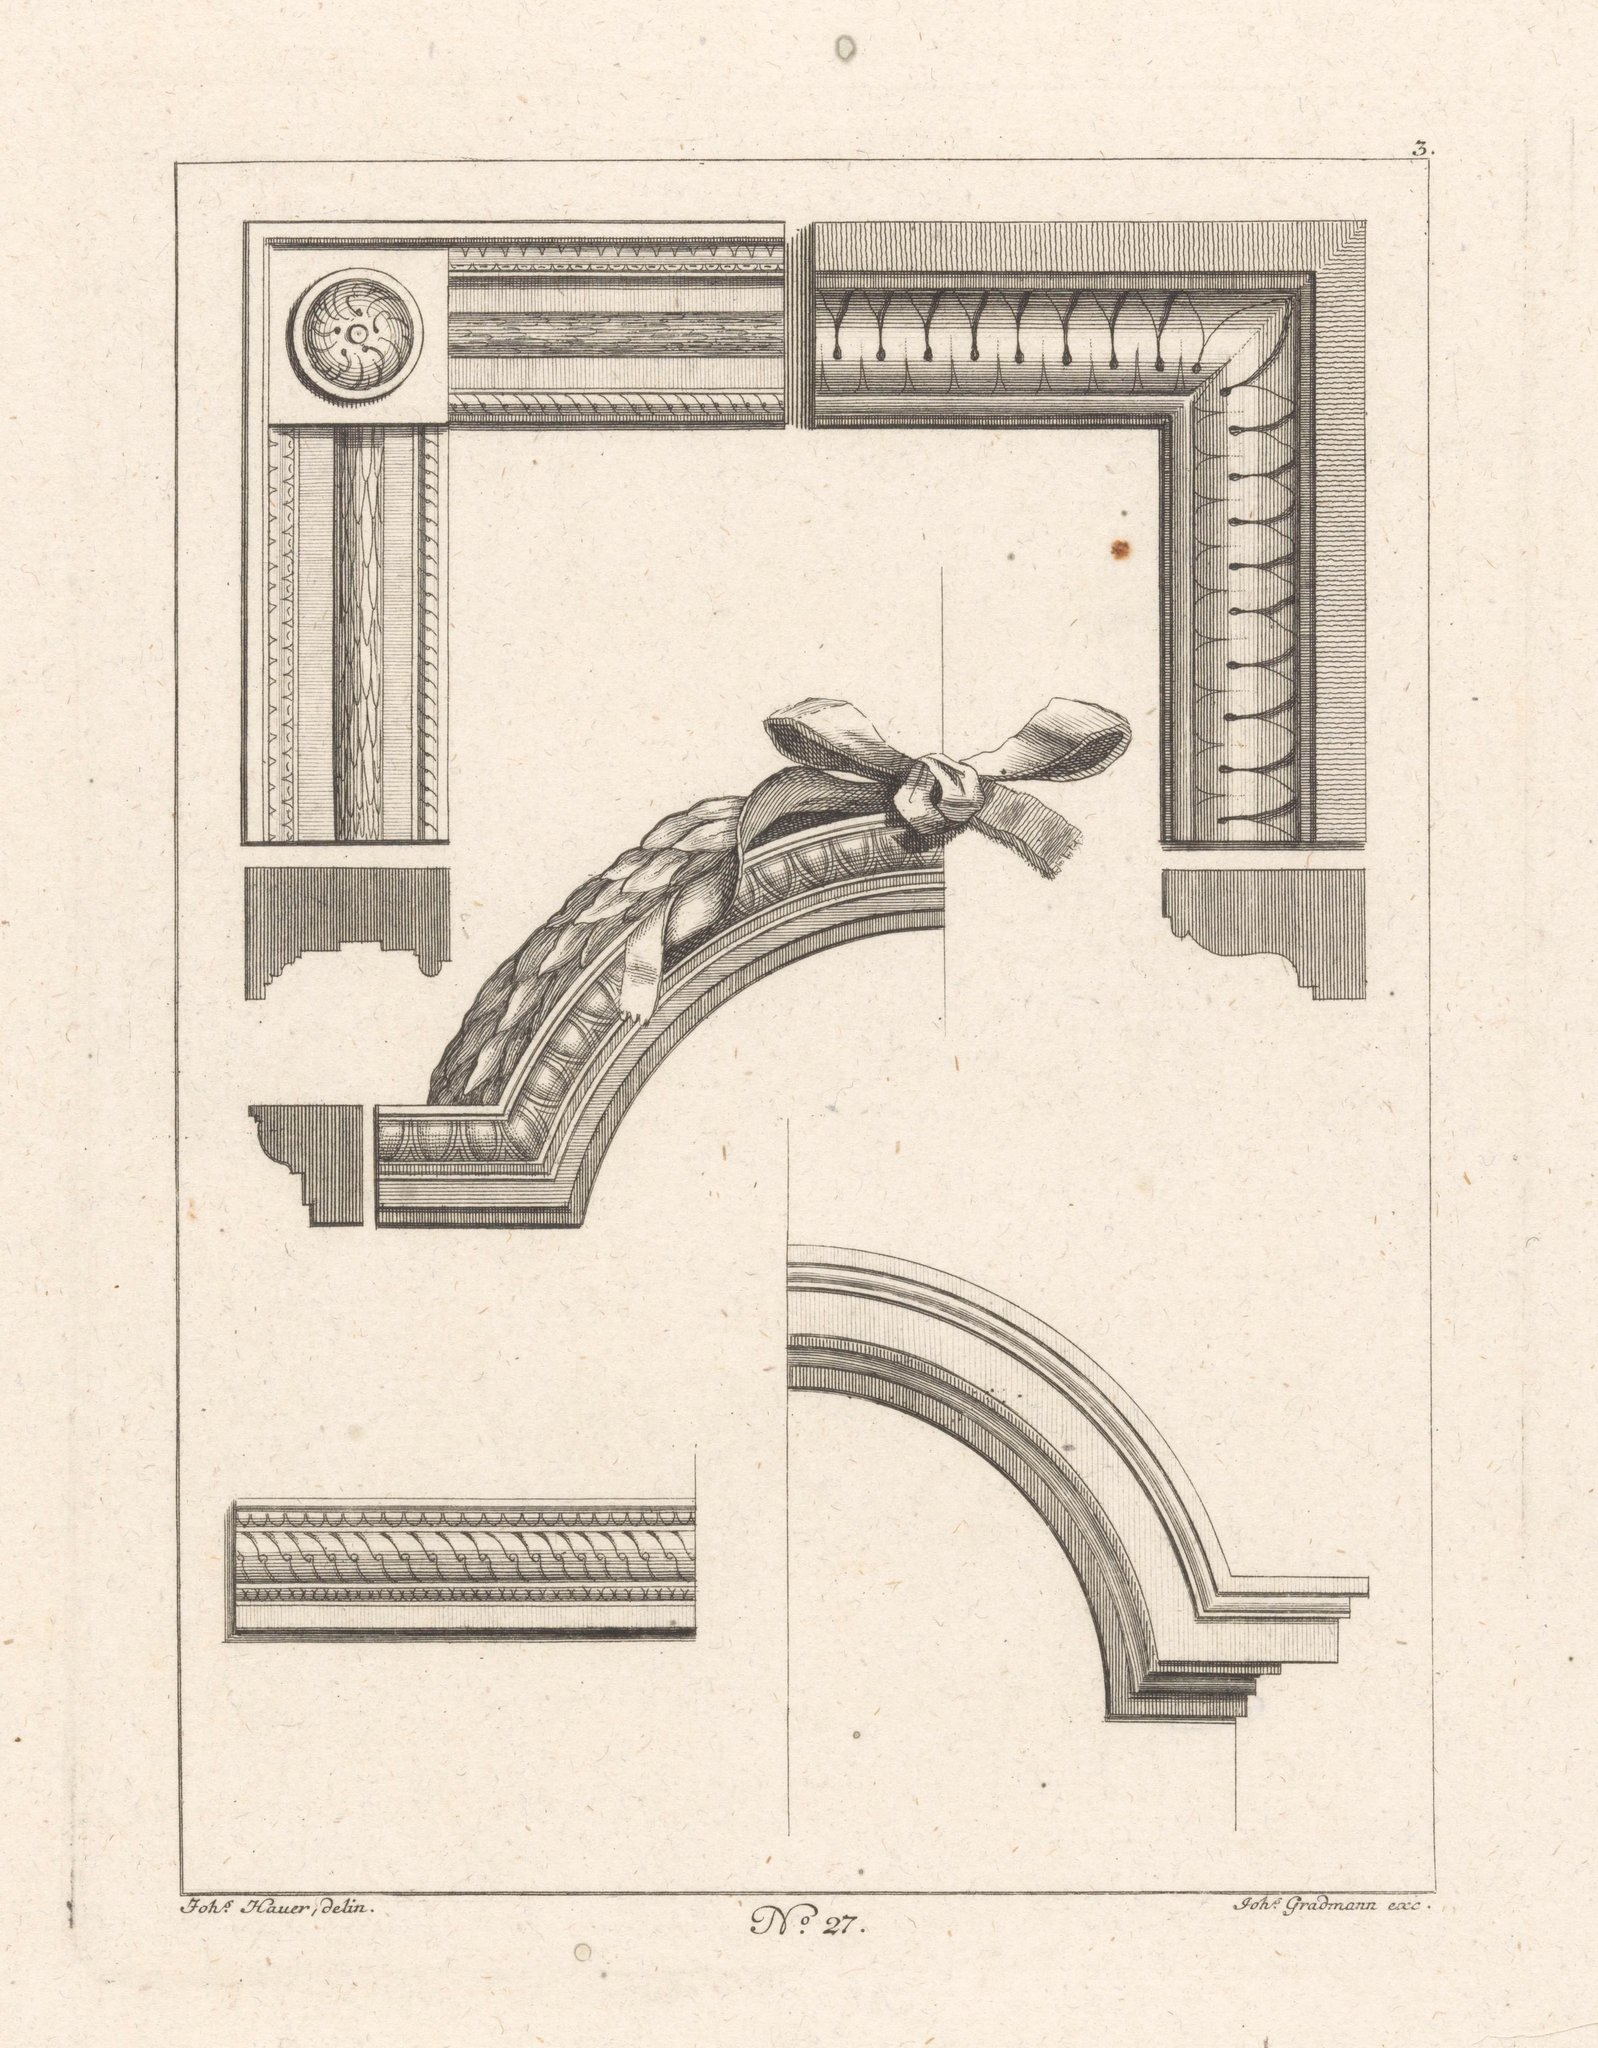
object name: print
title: Kroonlijsten en omlijstingen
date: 1758-1820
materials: paper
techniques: engraving, etching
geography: paris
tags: ornaments ~ art (+ framing decorations)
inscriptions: collector's mark: Lugt 2228, collector's mark: Lugt 2760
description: Ontwerpen voor vijf geornamenteerde lijsten, in het midden een lijst met strik en laurier. Uitgeversnummer 27.